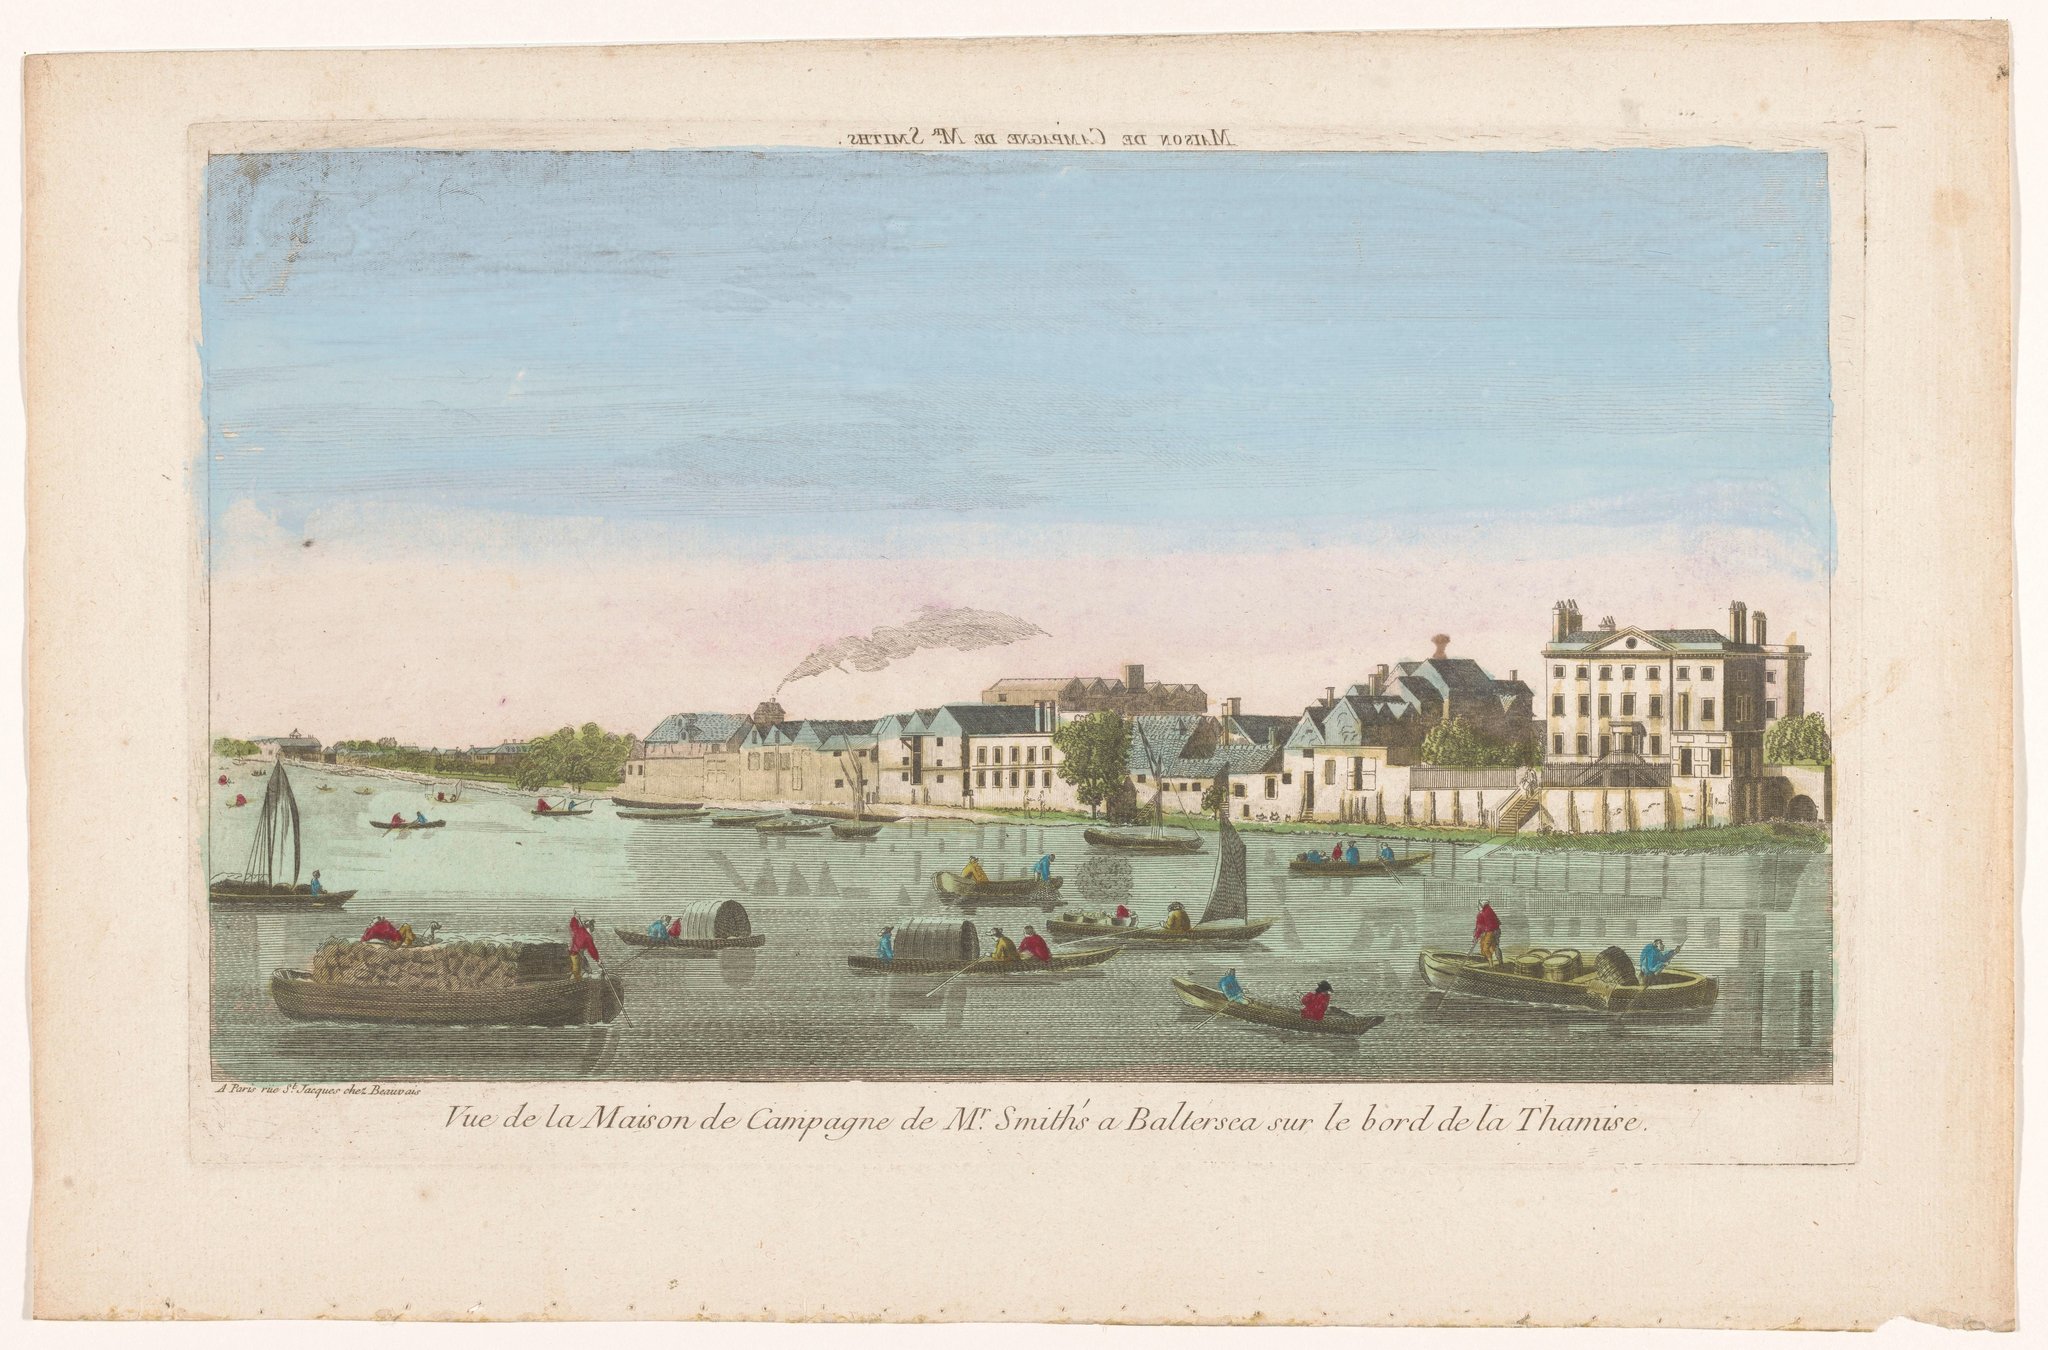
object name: print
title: Maison de campagne de Mr. Smiths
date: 1700-1799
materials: paper, watercolor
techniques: brush, etching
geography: paris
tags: sailing-ship, sailing-boat, rowing-boat, canoe, etc., canals, waters (in city) (+ city(-scape) with figures, staffage), country-house, thames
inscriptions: watermark, collector's mark: Lugt 2166